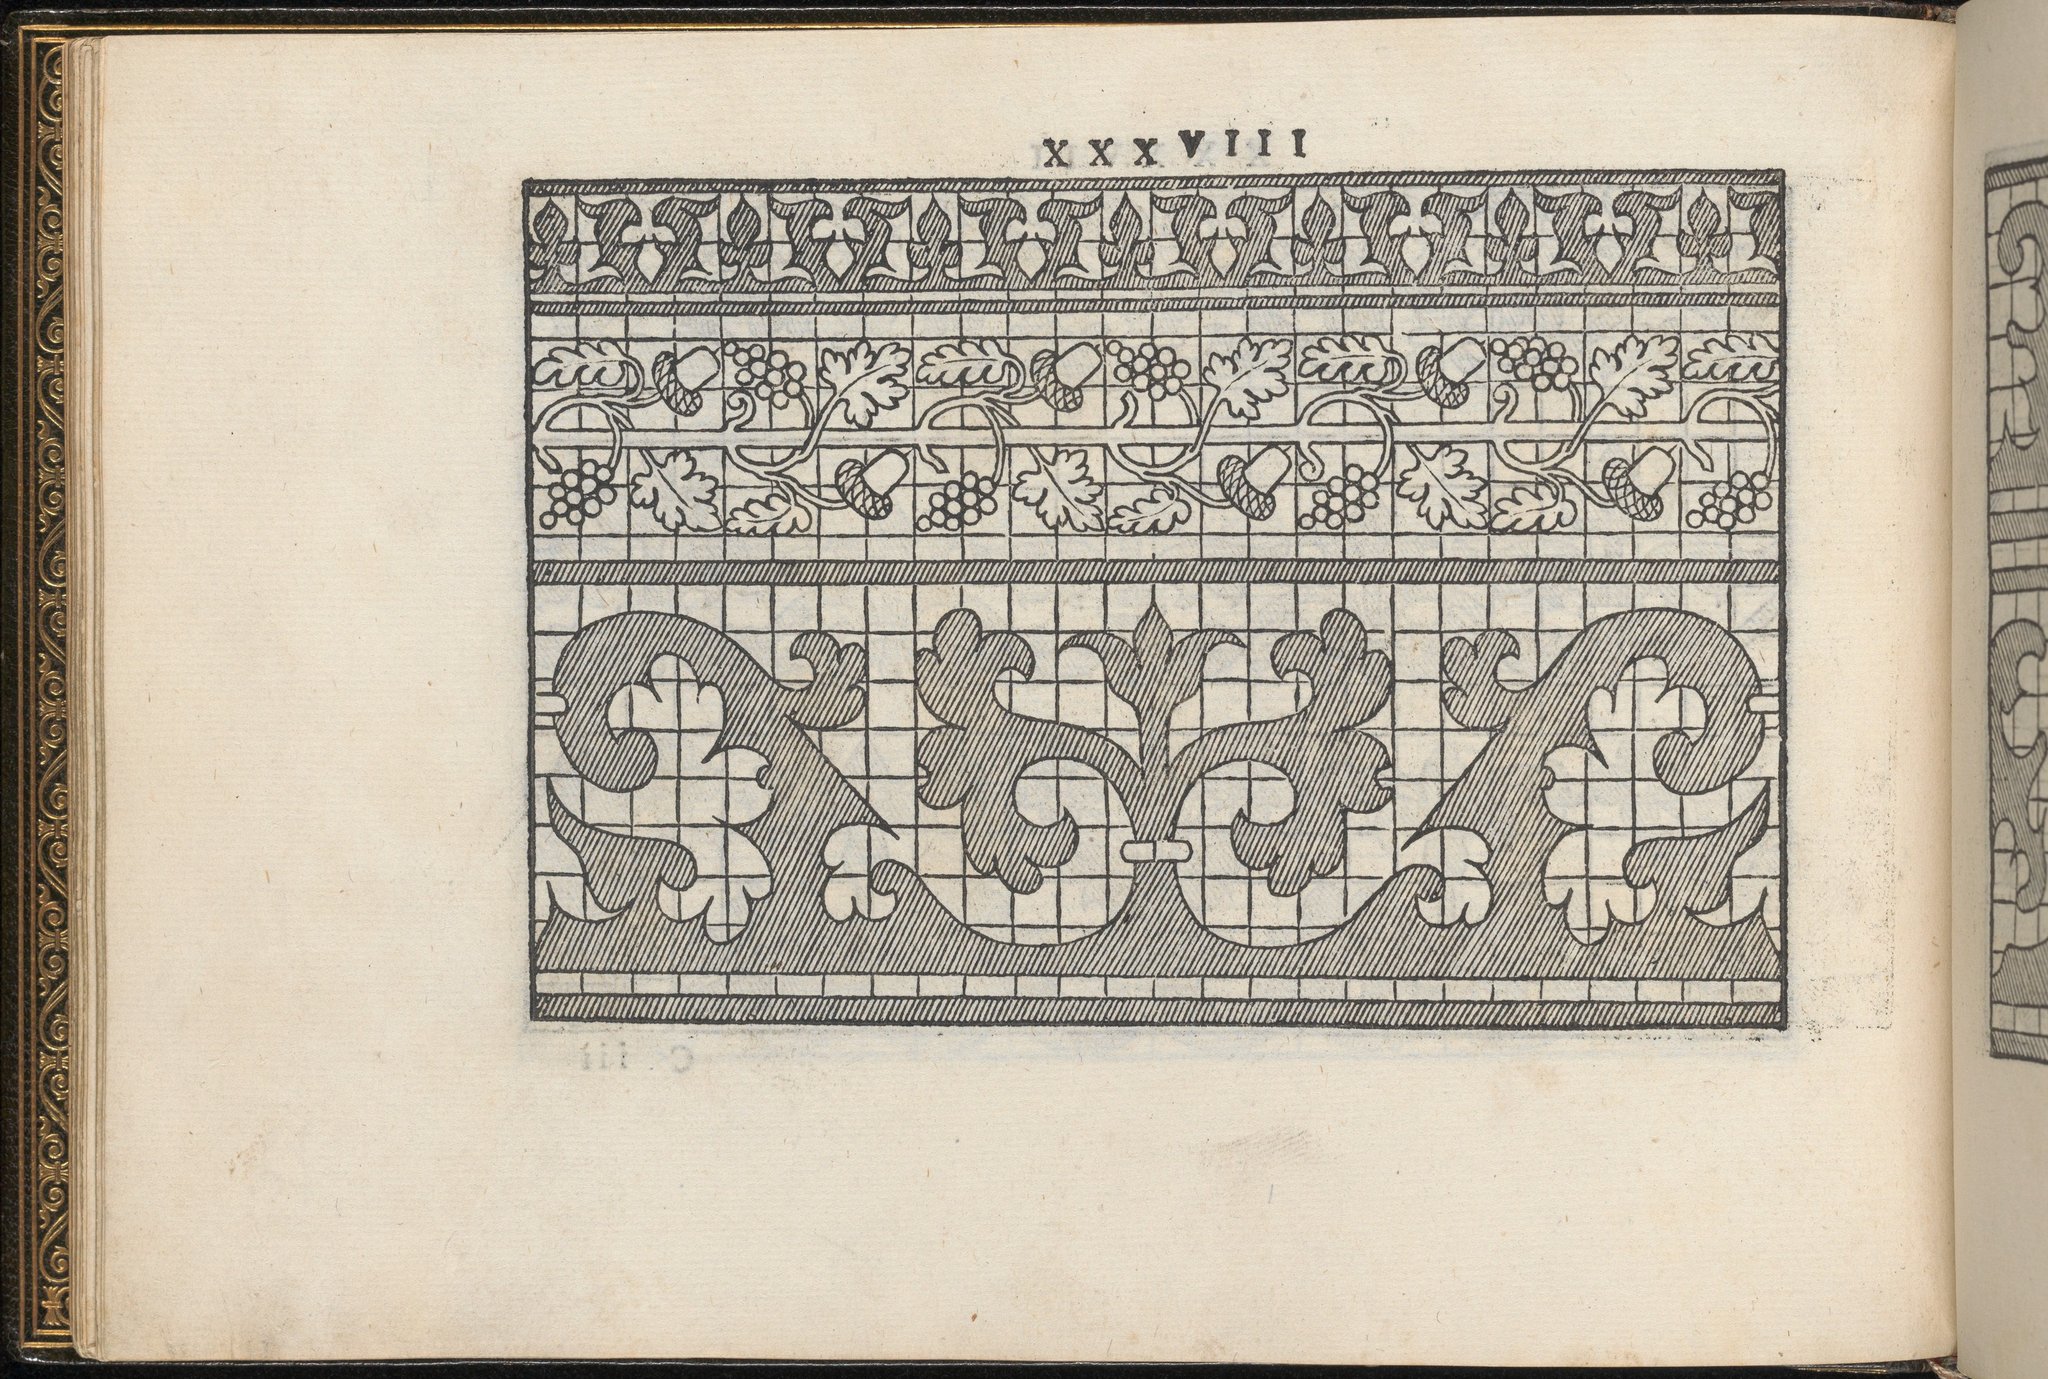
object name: book print ornament architecture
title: La Vera Perfettione del Disegno di varie sorti di recami, page 19 (verso)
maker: giovanni ostaus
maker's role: publisher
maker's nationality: italian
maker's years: 1507-1607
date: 1567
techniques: woodcut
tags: grapes